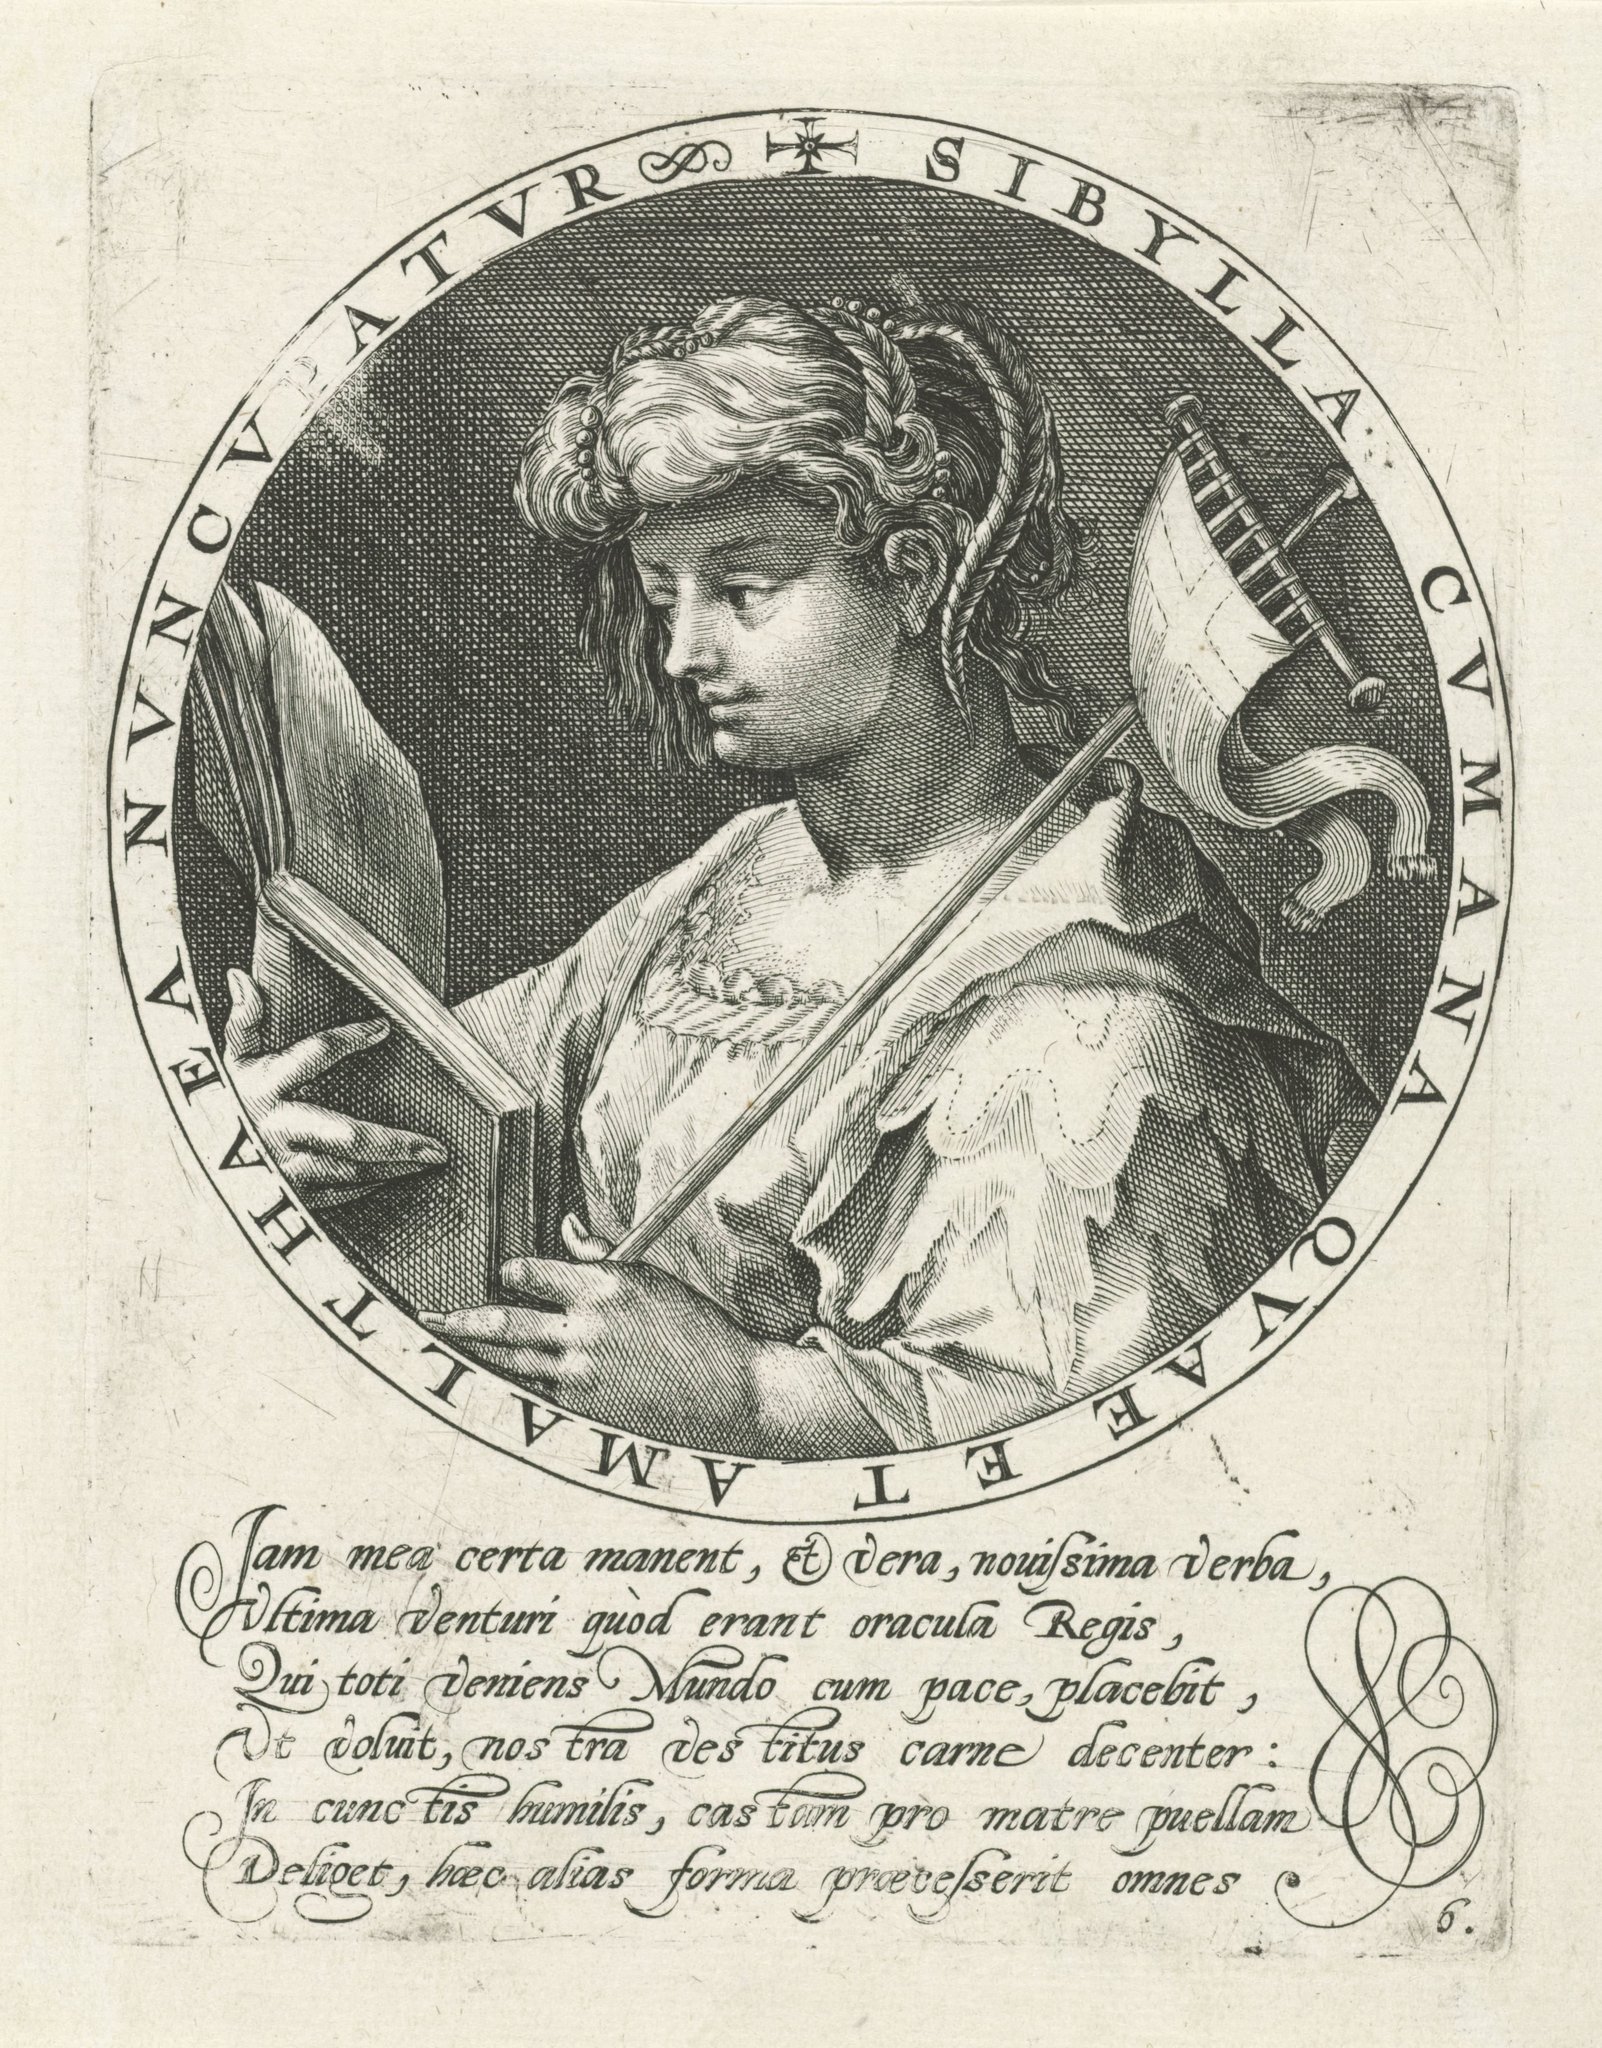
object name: print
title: XII. Sibyllarum Icones Elegantissimi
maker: crispijn van de passe (i)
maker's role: draughtsman, print maker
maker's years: 1564-1637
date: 1601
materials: paper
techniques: engraving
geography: cologne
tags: sibyls (with name)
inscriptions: collector's mark: Lugt 2228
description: Buste van de Cimmerische Sibille, lezend in een boek. In haar linkerhand houdt ze een vaandel. De voorstelling is gevat in een medaillon met een randschrift in het Latijn. In de marge een zesregelig onderschrift in het Latijn. Prent uit een serie met de twaalf sibillen.